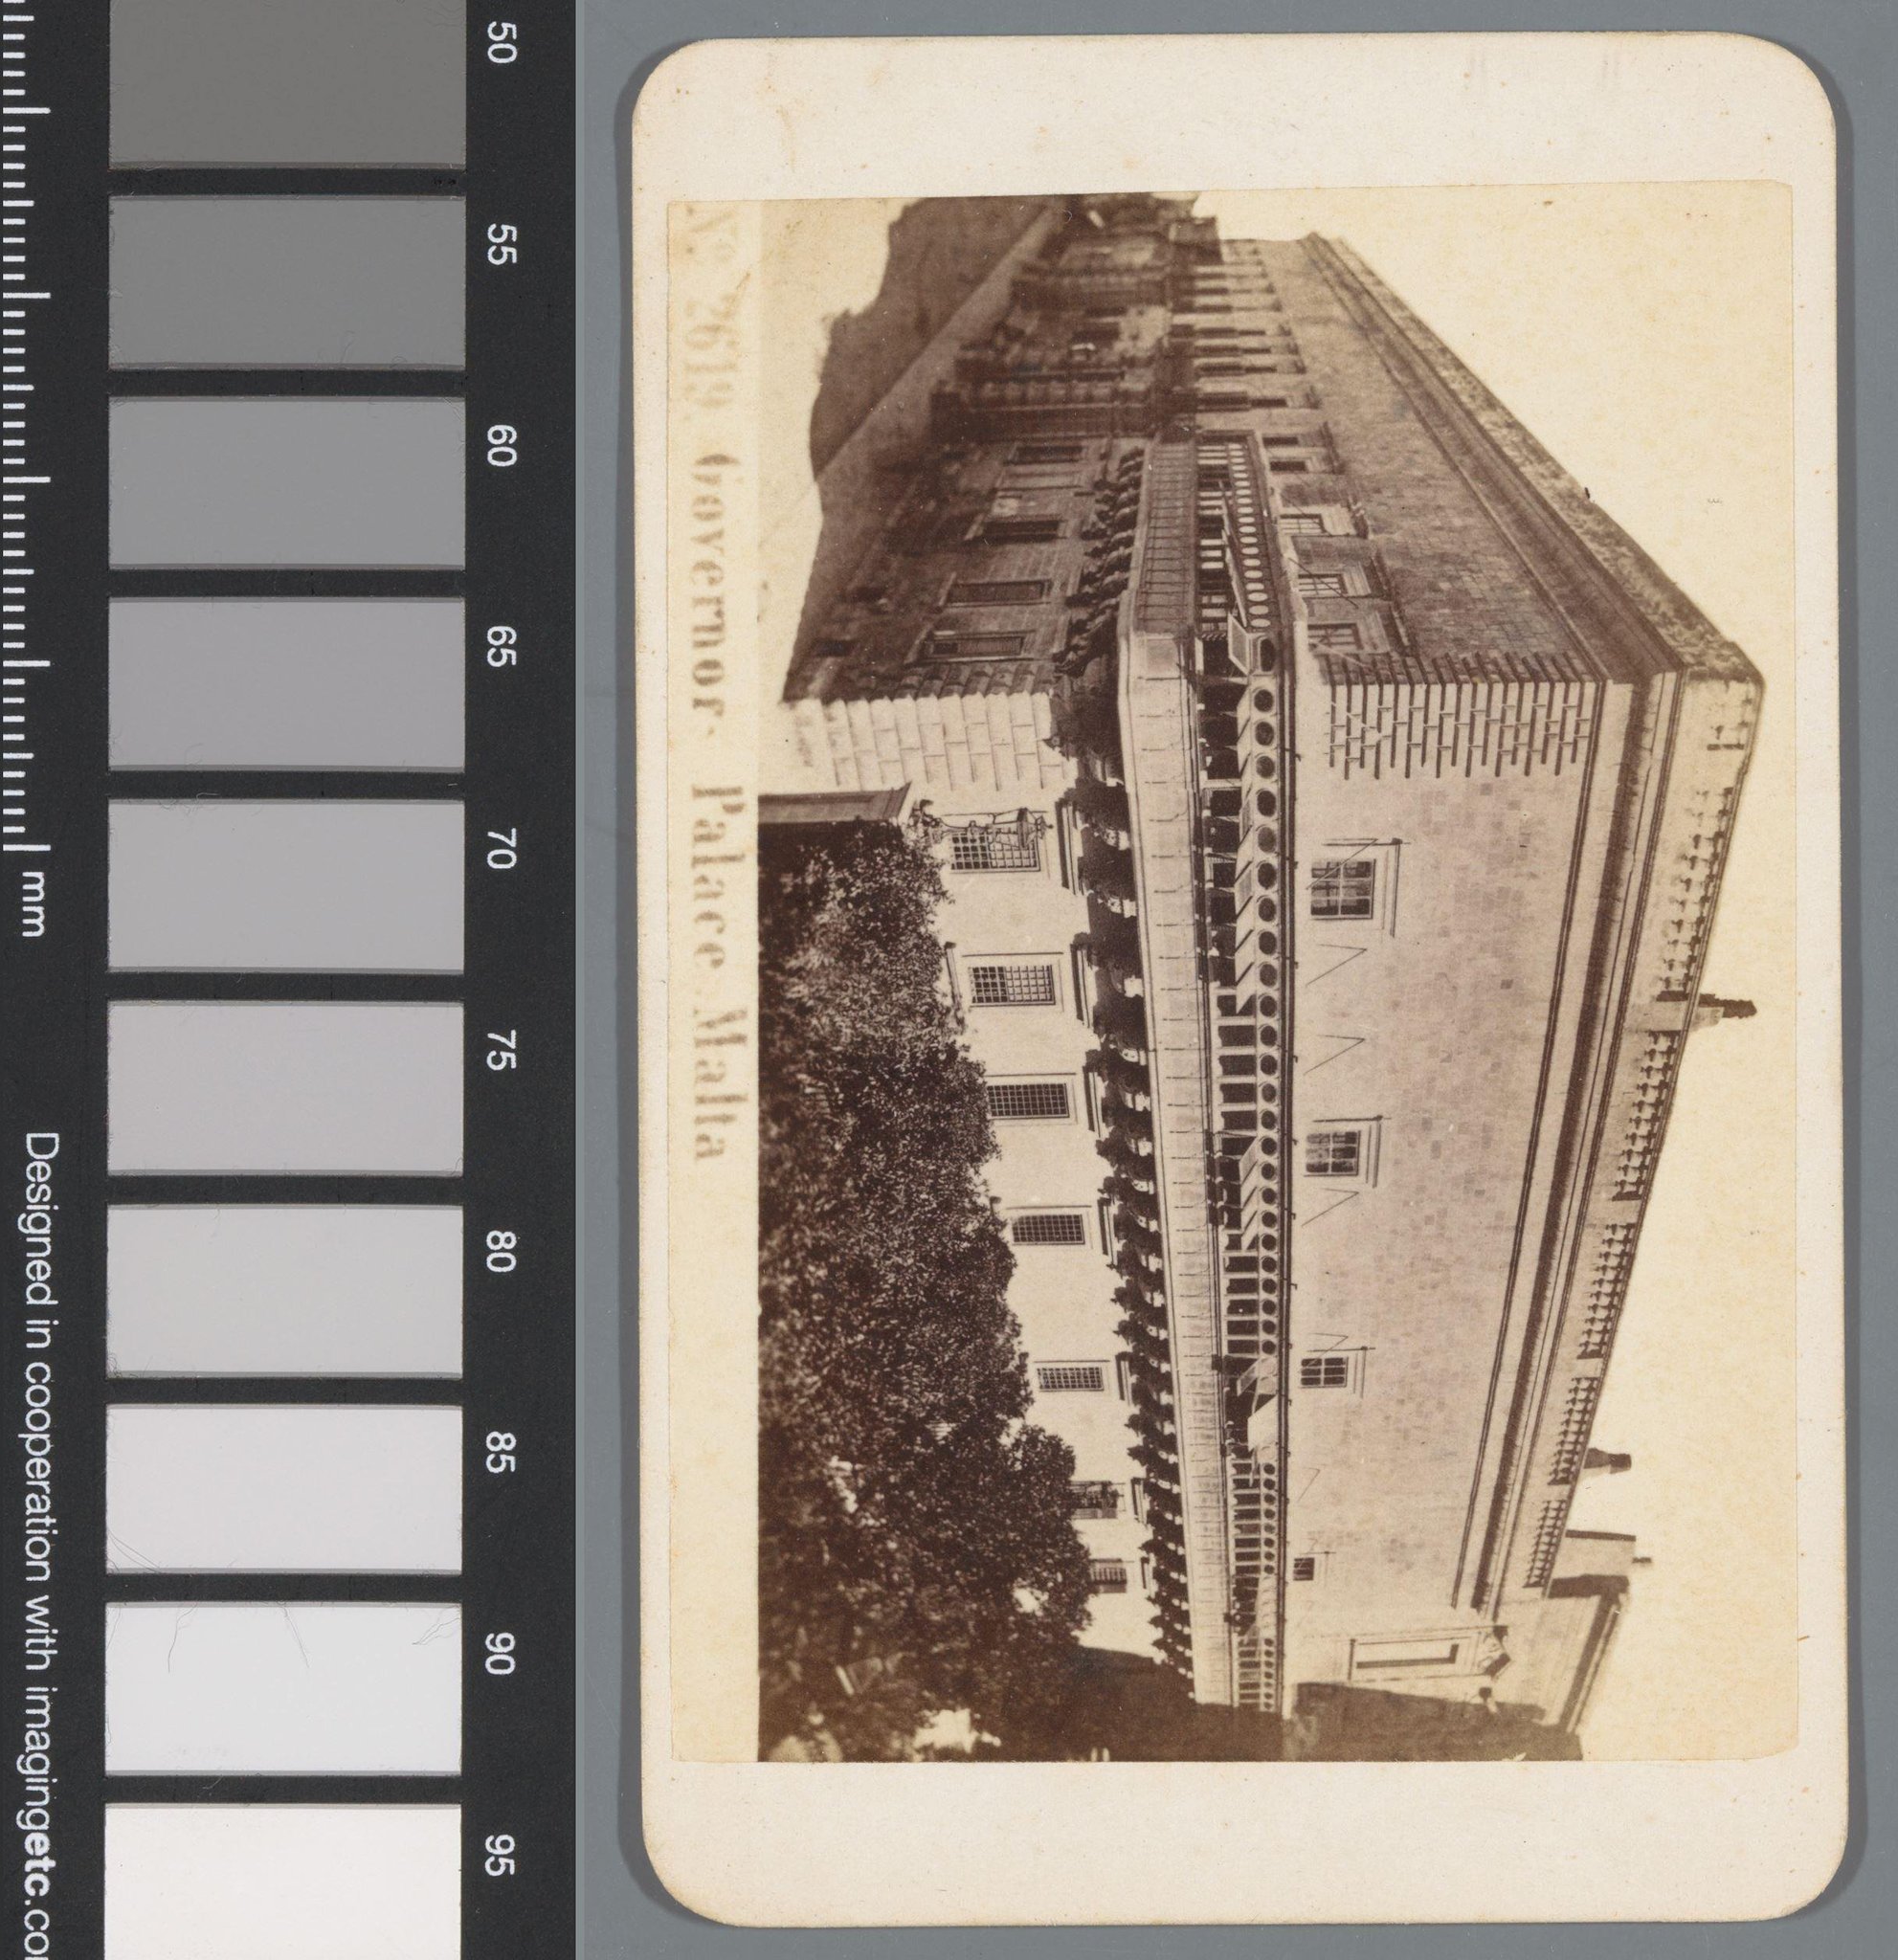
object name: carte de visite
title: Governor' Palace, Malta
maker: giorgio sommer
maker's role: fotograaf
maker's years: 1834-1914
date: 1865-1888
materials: cardboard, paper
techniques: albumen print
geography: valletta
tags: palace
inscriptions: number: ‘No. 2619.’, inscription: ‘Grandes Médailles d'or/ Georges Sommer/ Photographe/ Naples/ Atelier Monte di Dio No. 4 au 1er/ Magasin Sta. Caterina No. 5./ Lit. Richter & Co.’